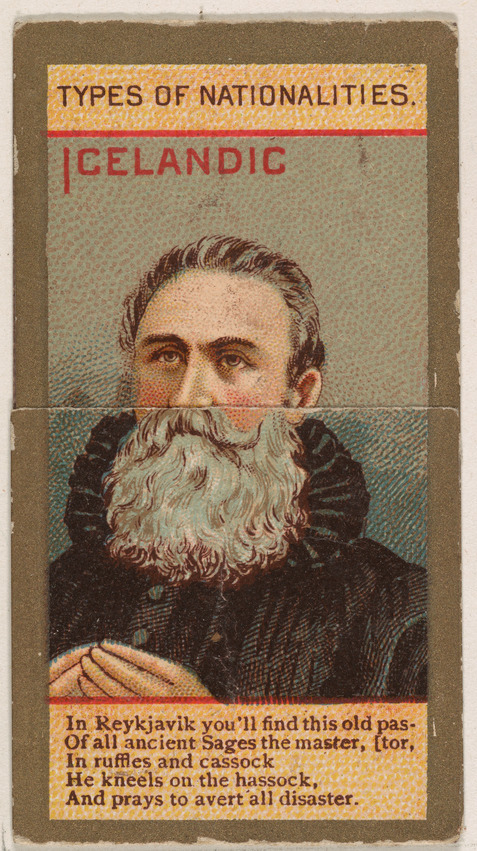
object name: print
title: Icelandic, from Types of Nationalities (N240) issued by Kinney Bros.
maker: kinney brothers tobacco company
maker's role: publisher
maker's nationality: american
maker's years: 1869-2011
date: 1890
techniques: color lithograph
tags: men,smoking